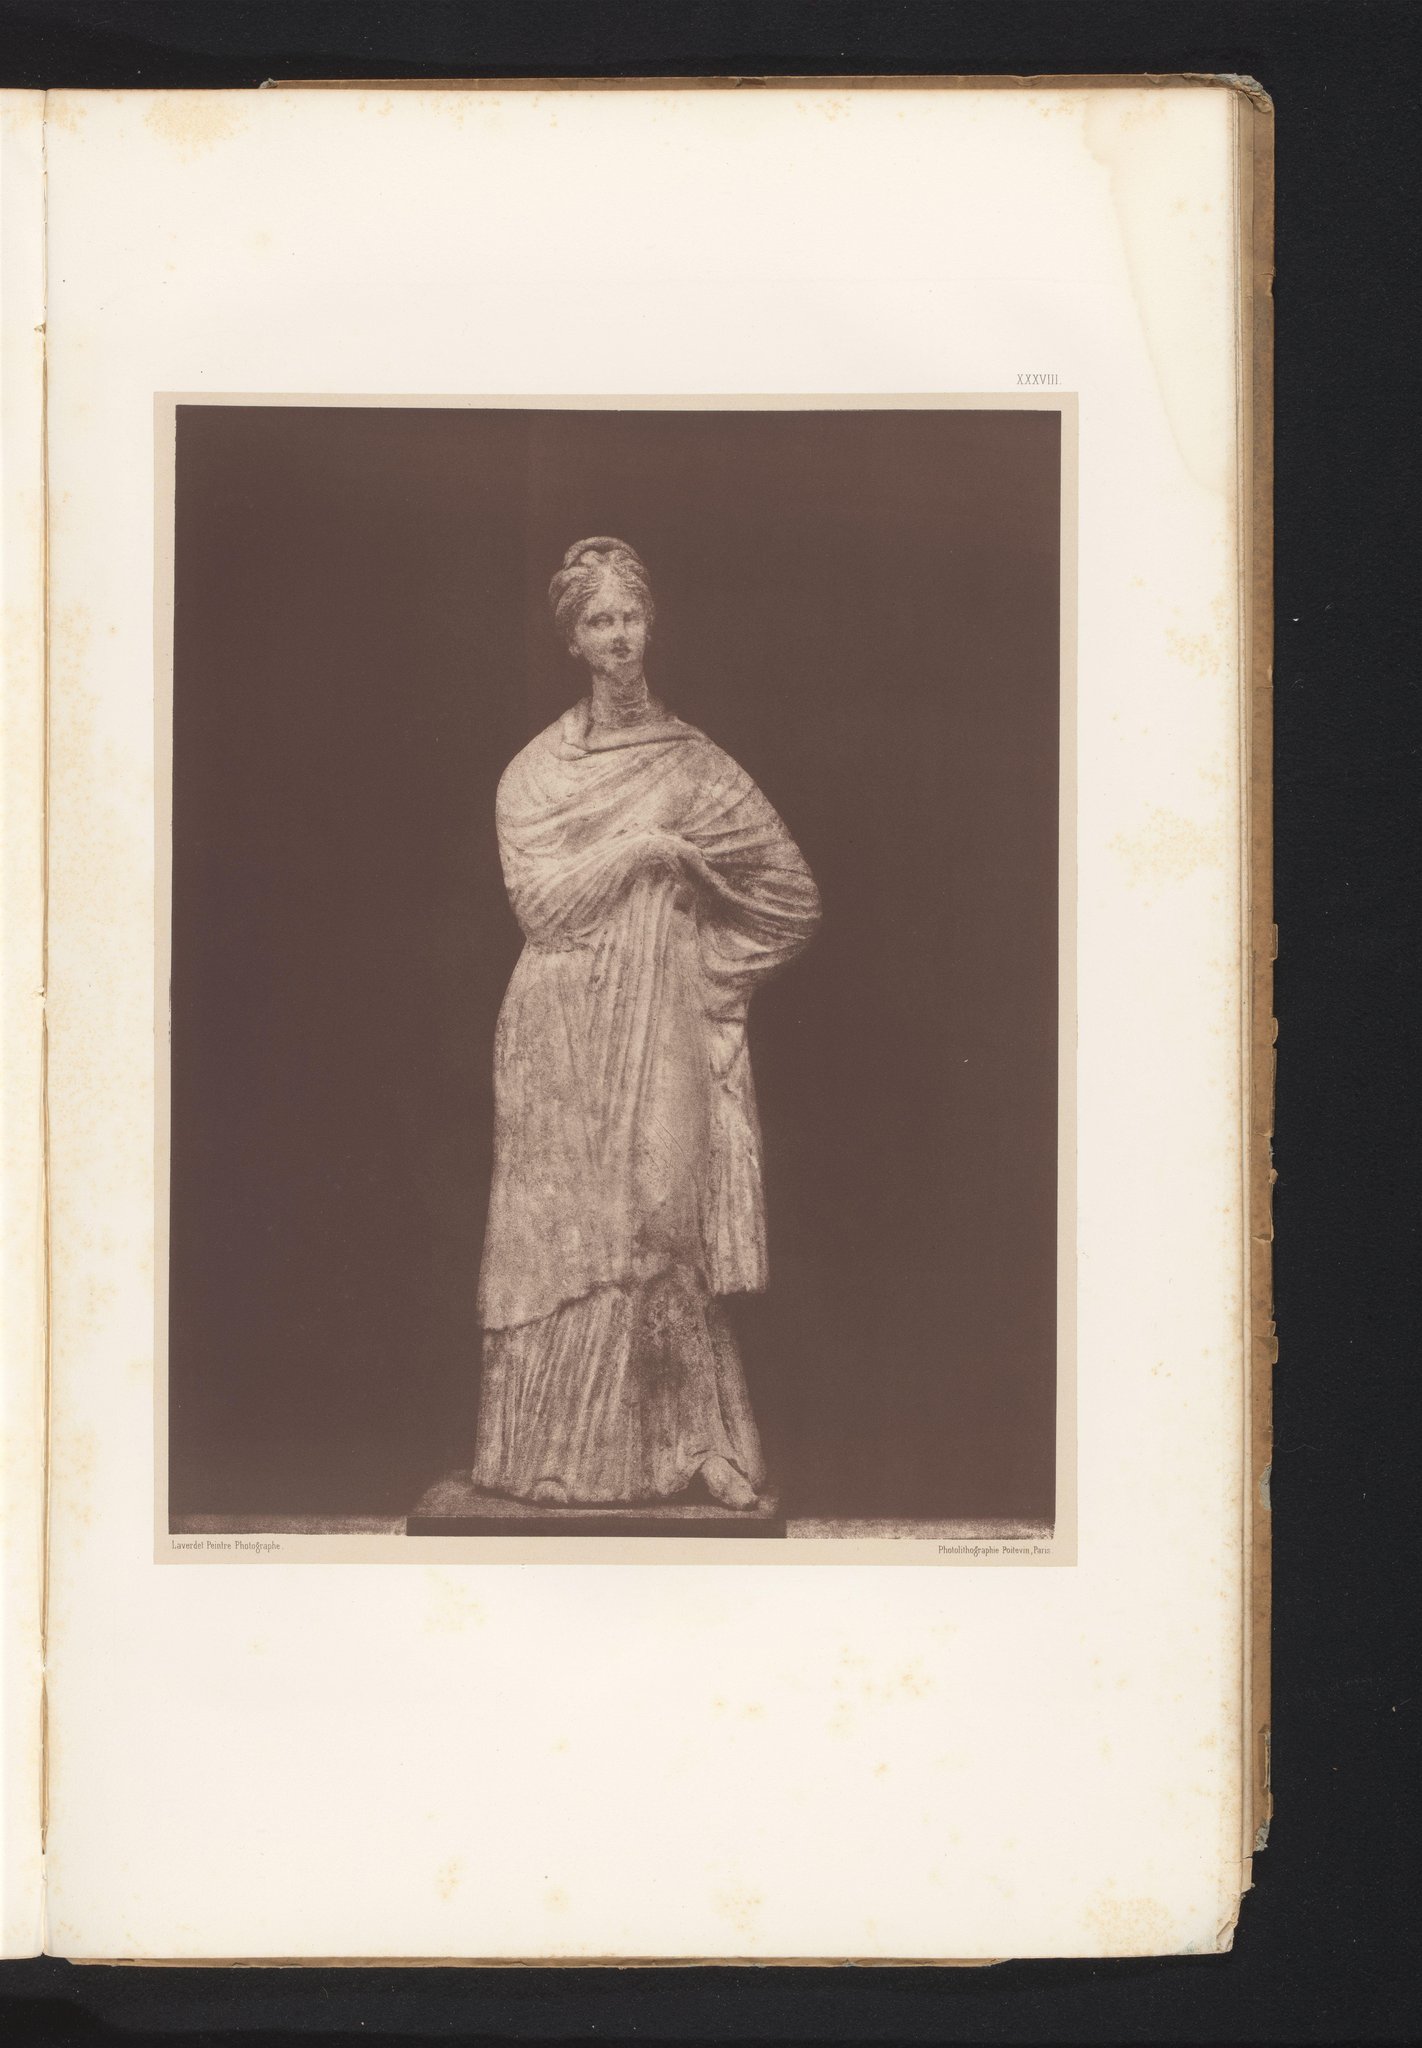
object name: photomechanical print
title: Terracotta sculptuur van een muze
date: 1852-1857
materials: paper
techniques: photolithography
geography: paris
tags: piece of sculpture, reproduction of a piece of sculpture (+ clay, sand, etc. ~ arts), single muses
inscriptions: number: ‘XXXVIII.’